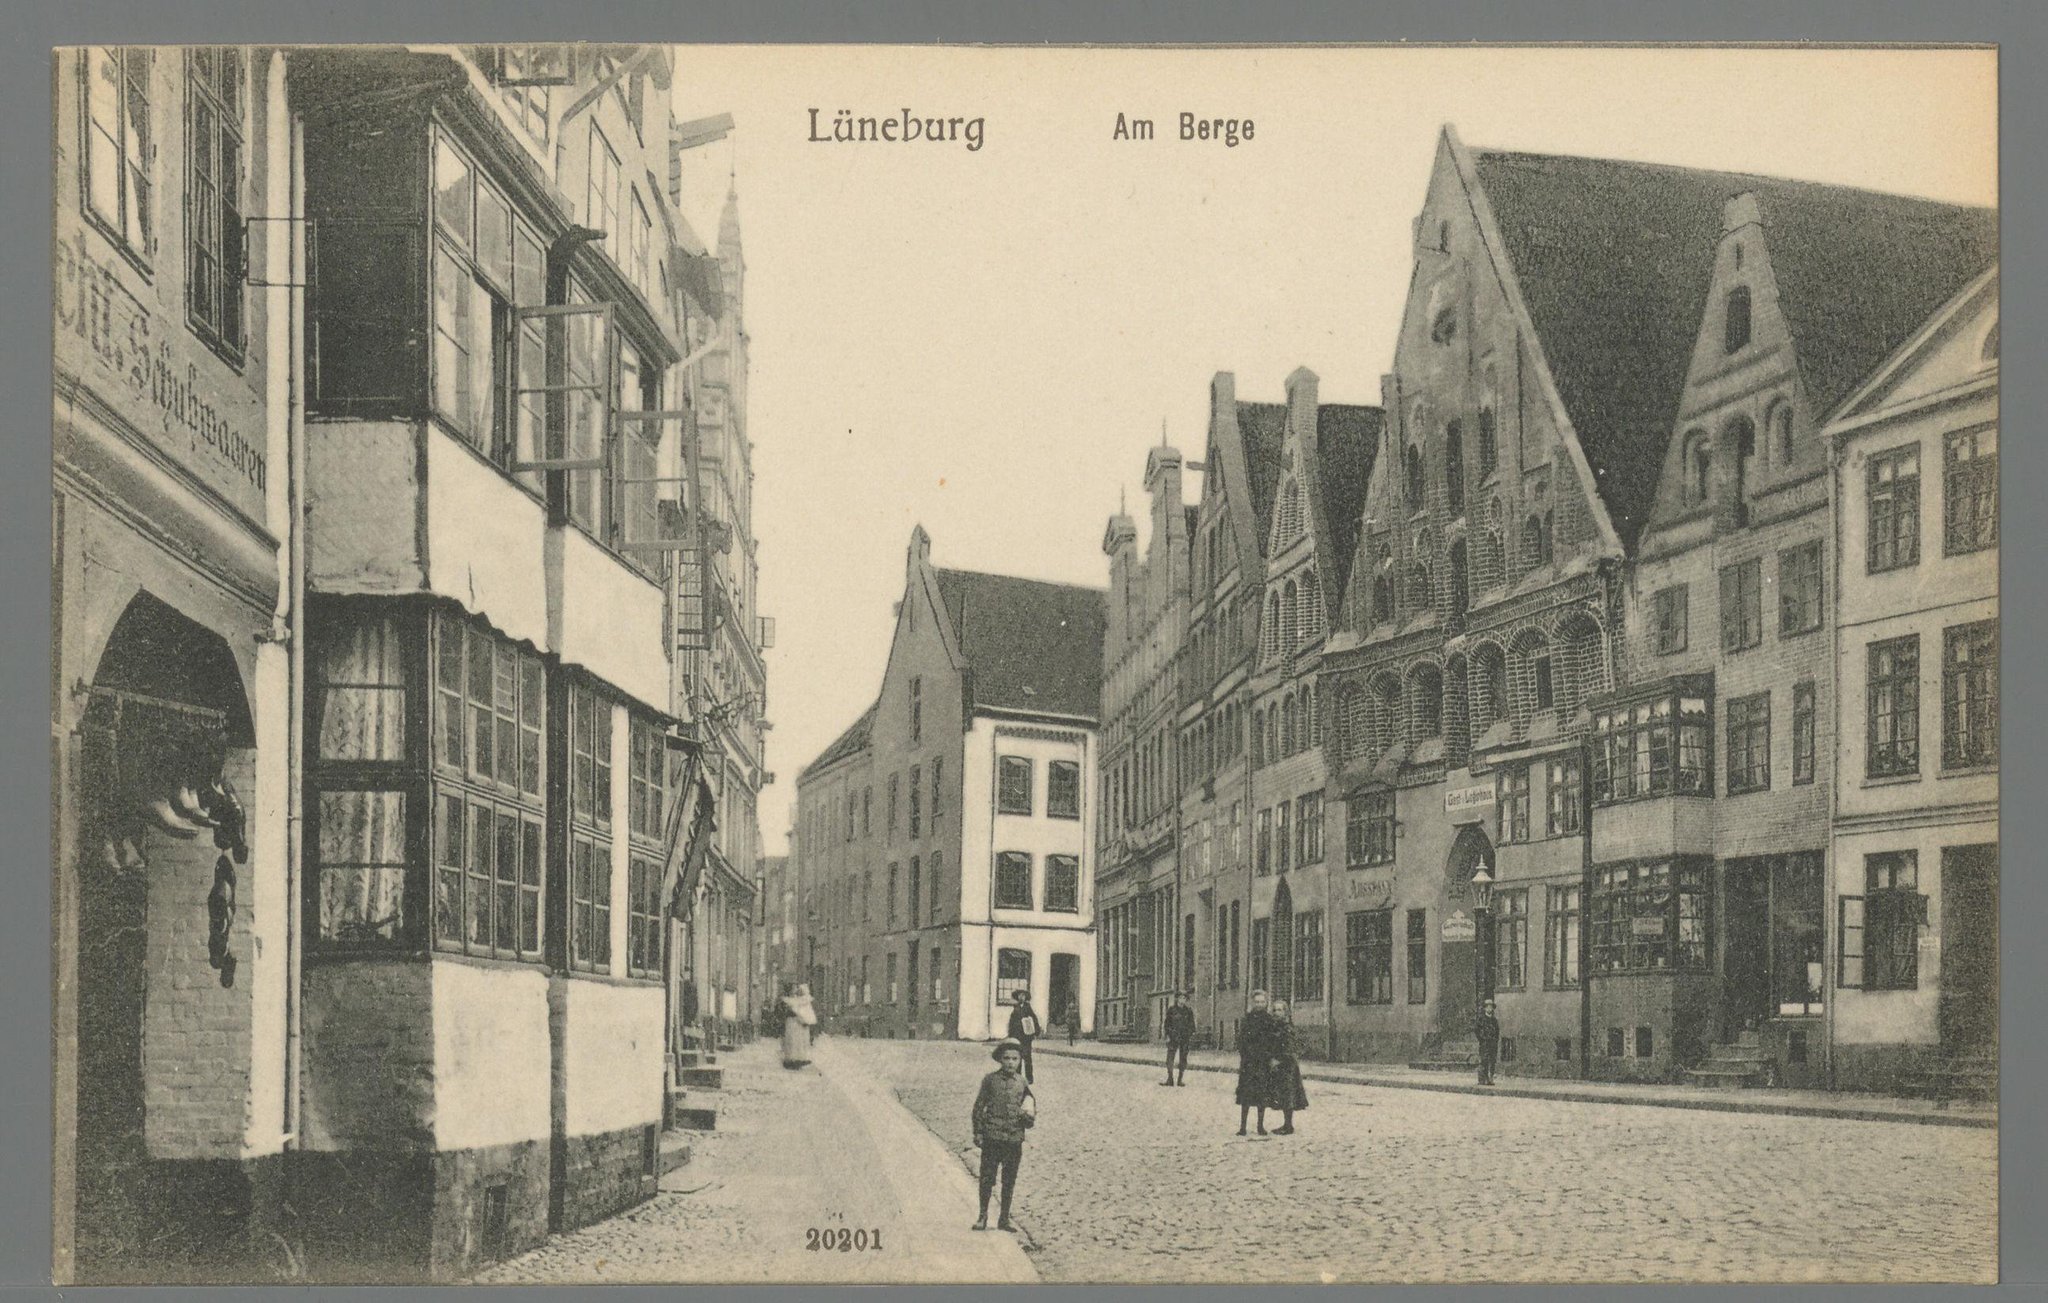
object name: ansichtkaart, prentbriefkaart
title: Lüneburg. Am Berge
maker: Anonymous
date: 1906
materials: cardboard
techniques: photograph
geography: magdeburg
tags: street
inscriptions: date